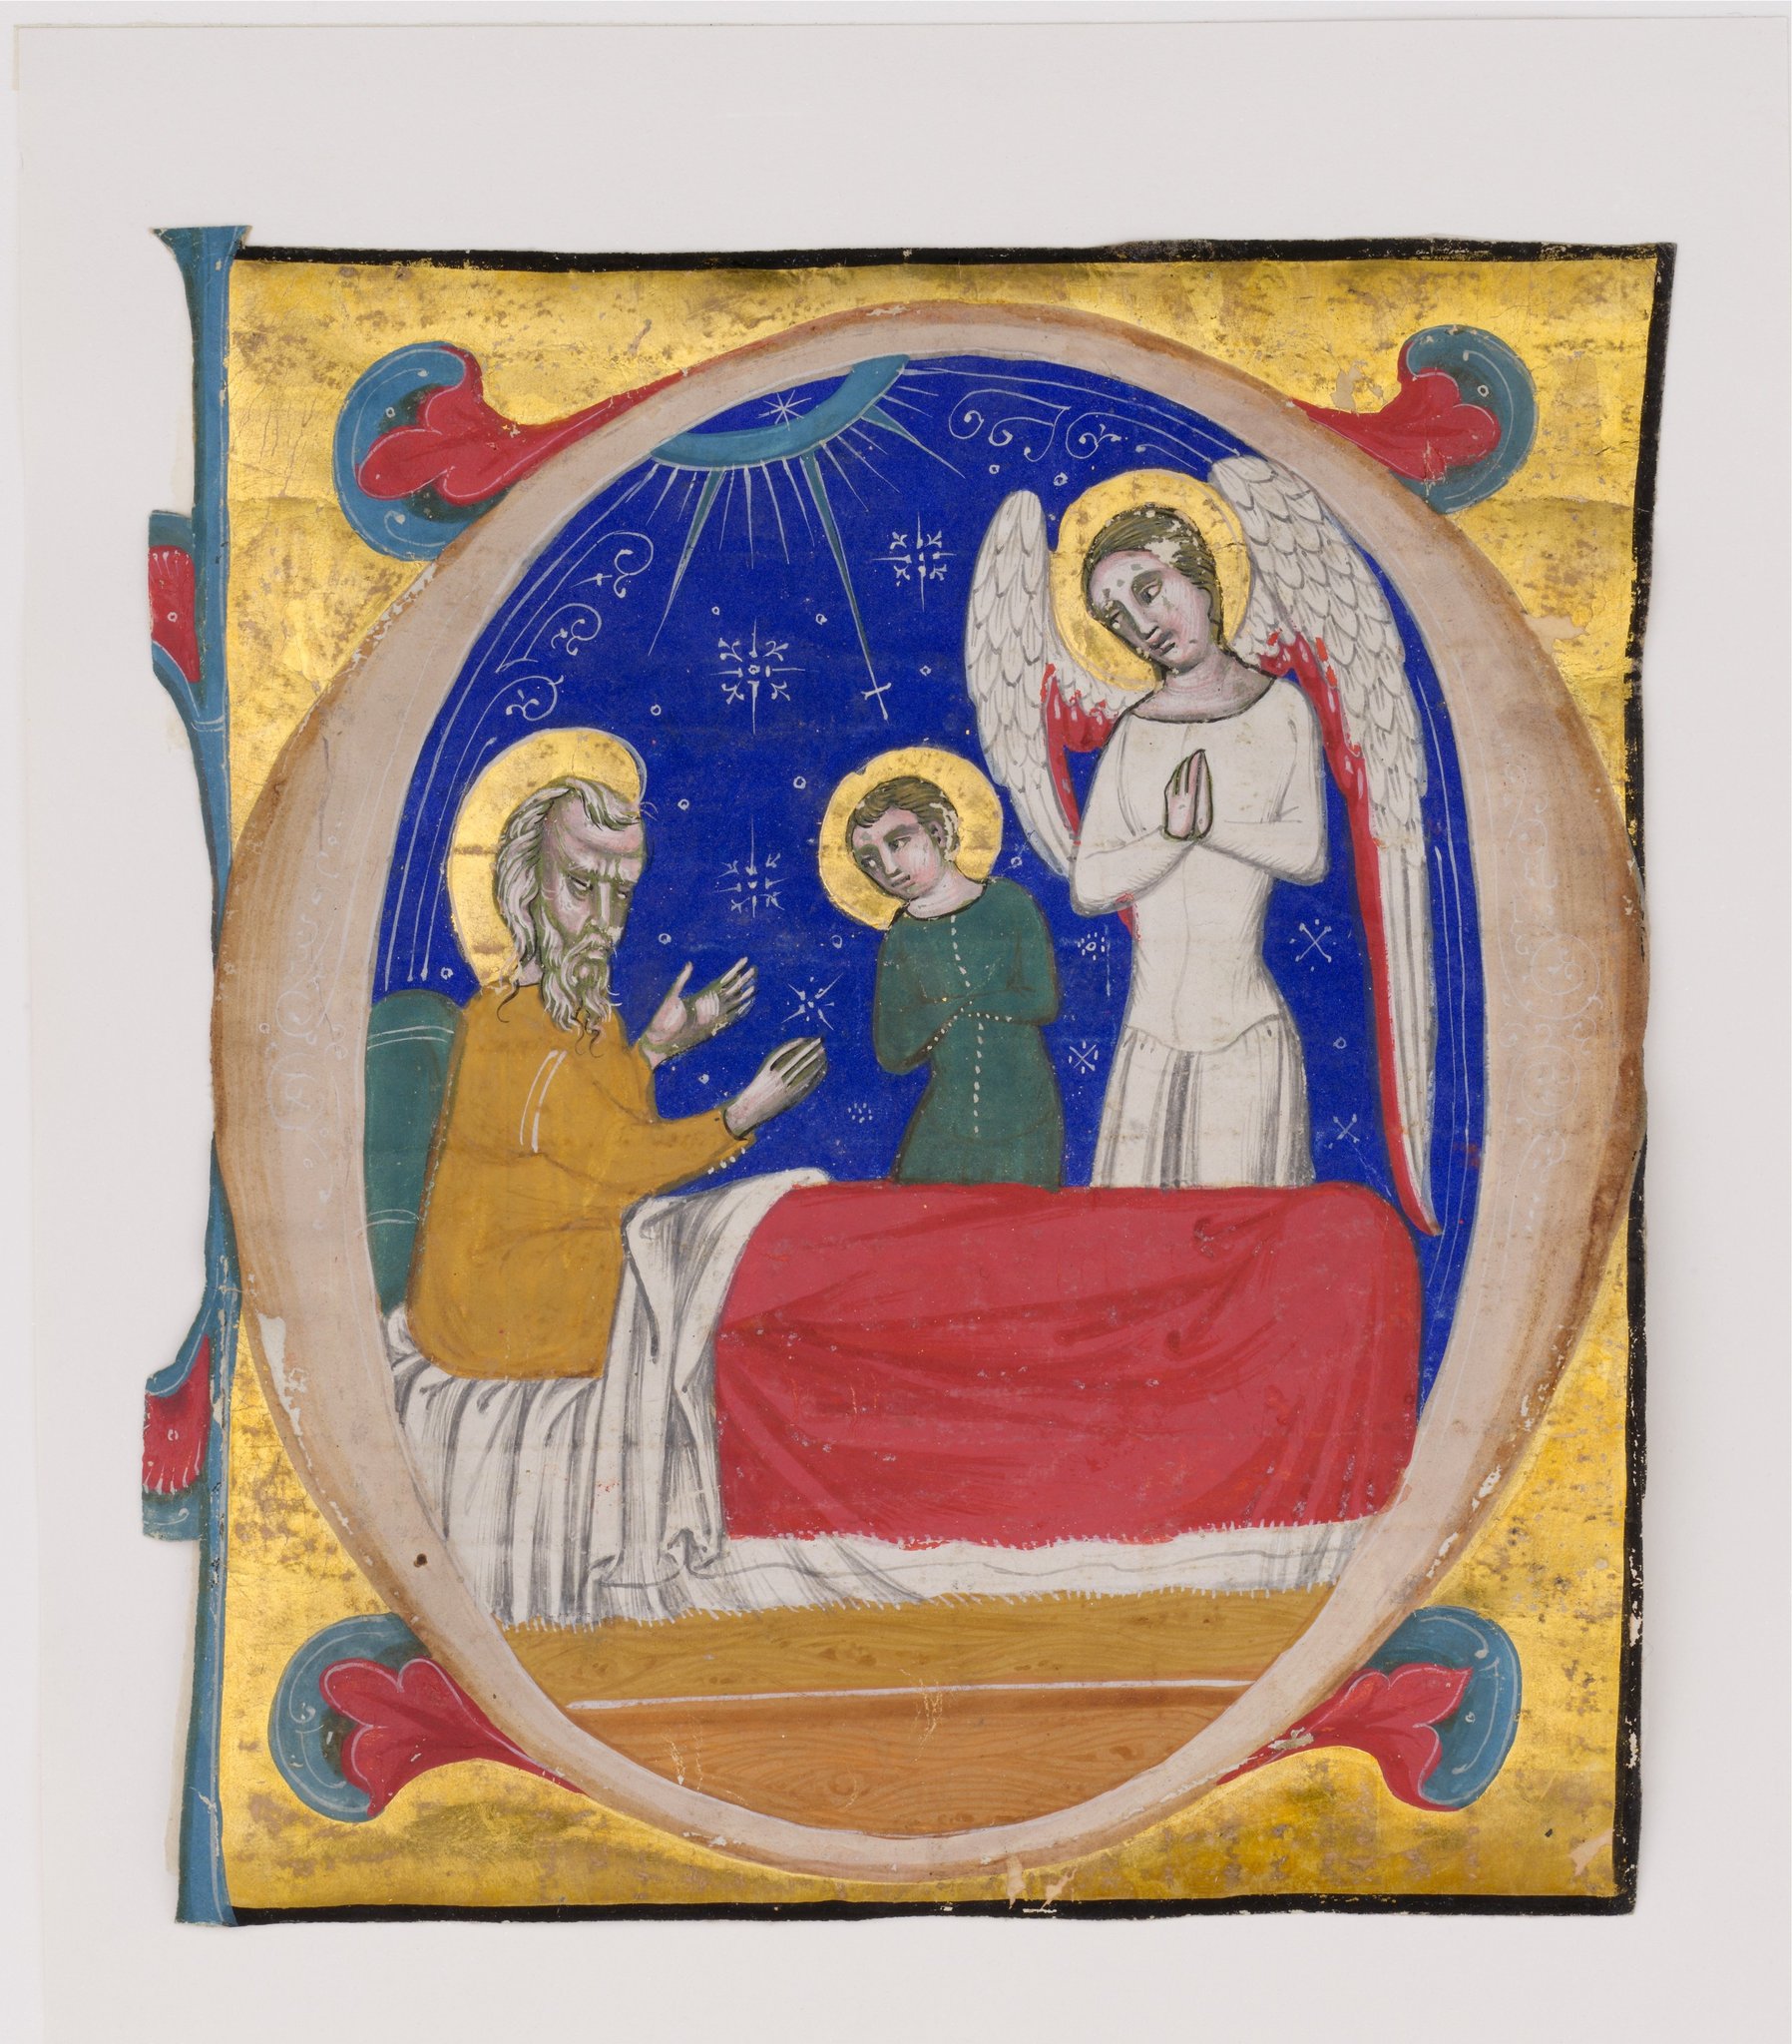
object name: antiphonary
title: Manuscript Illumination with Tobit, Tobias, and the Archangel Raphael in an Initial O, from an Antiphonary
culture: italian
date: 1334-1366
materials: gold, ink, parchment, paint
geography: italy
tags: men,angels